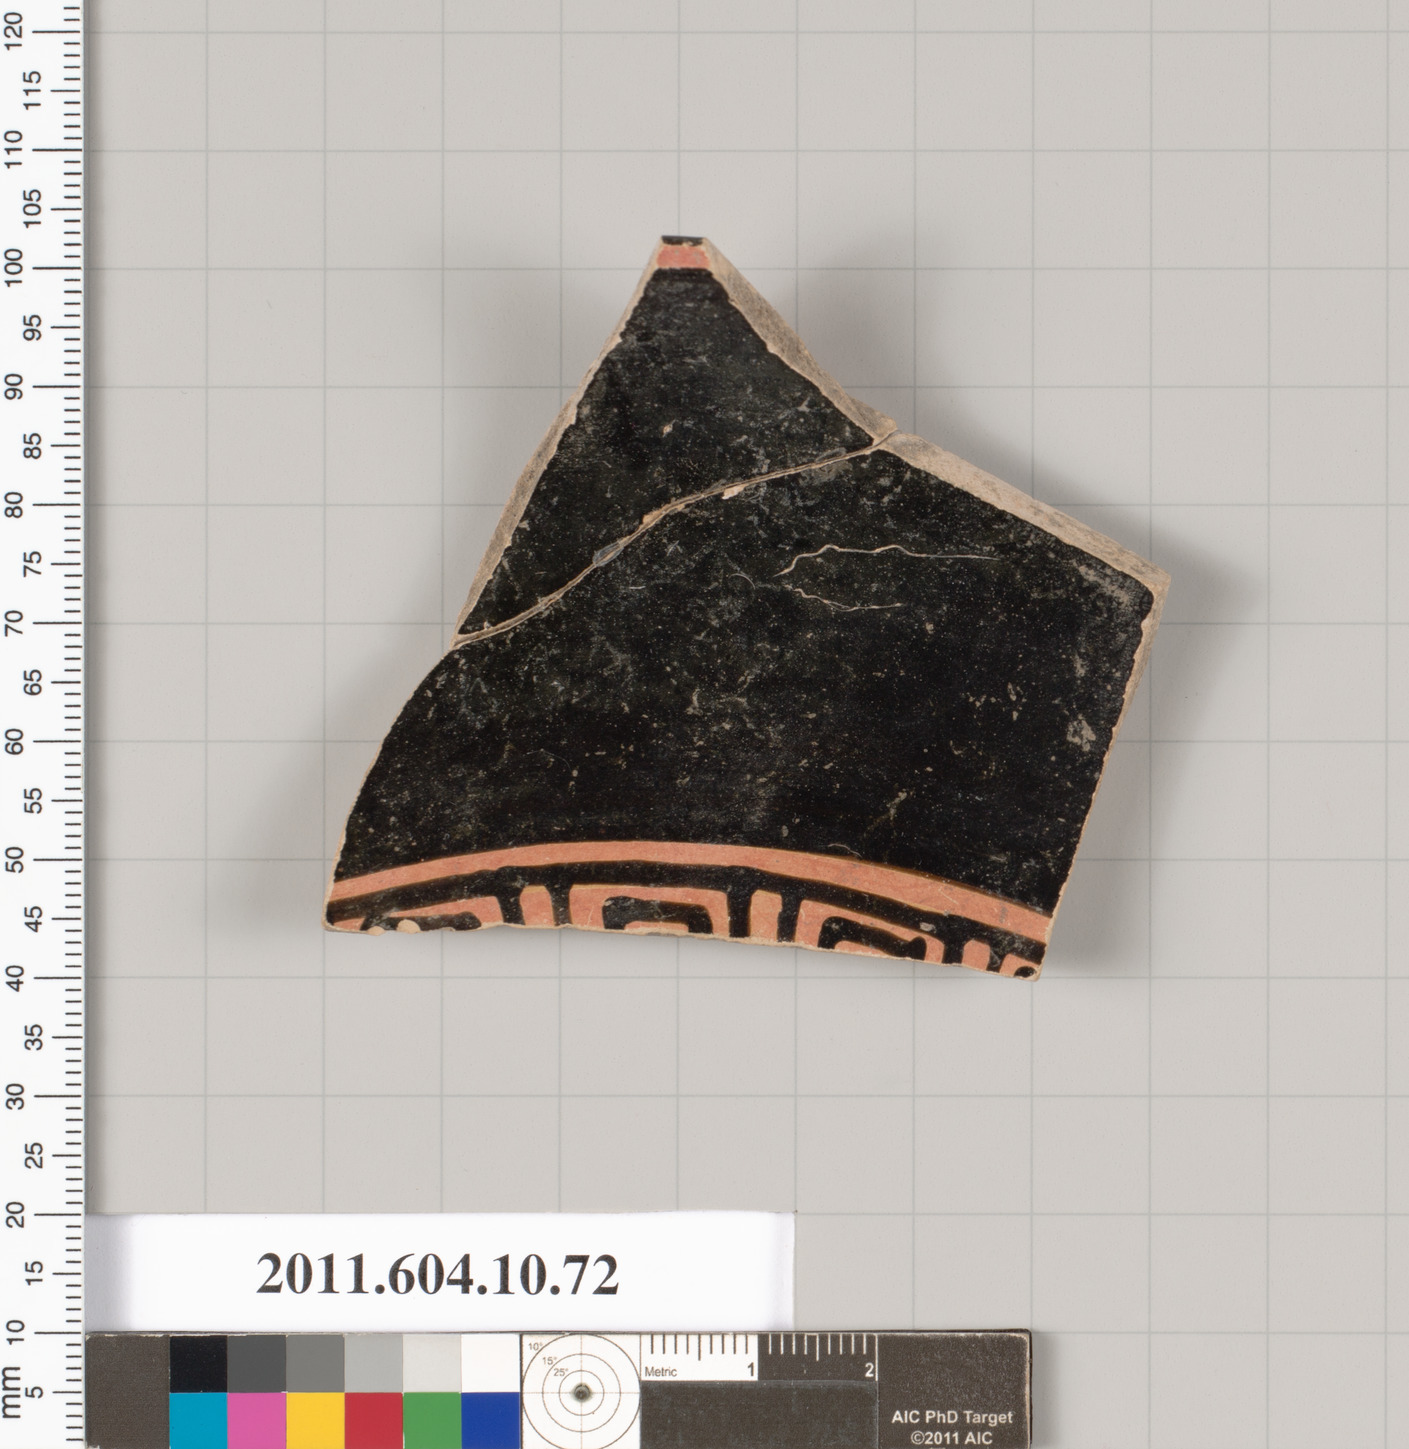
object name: kylix fragment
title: Terracotta fragment of a kylix (drinking cup)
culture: etruscan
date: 334-301 BCE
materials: terracotta